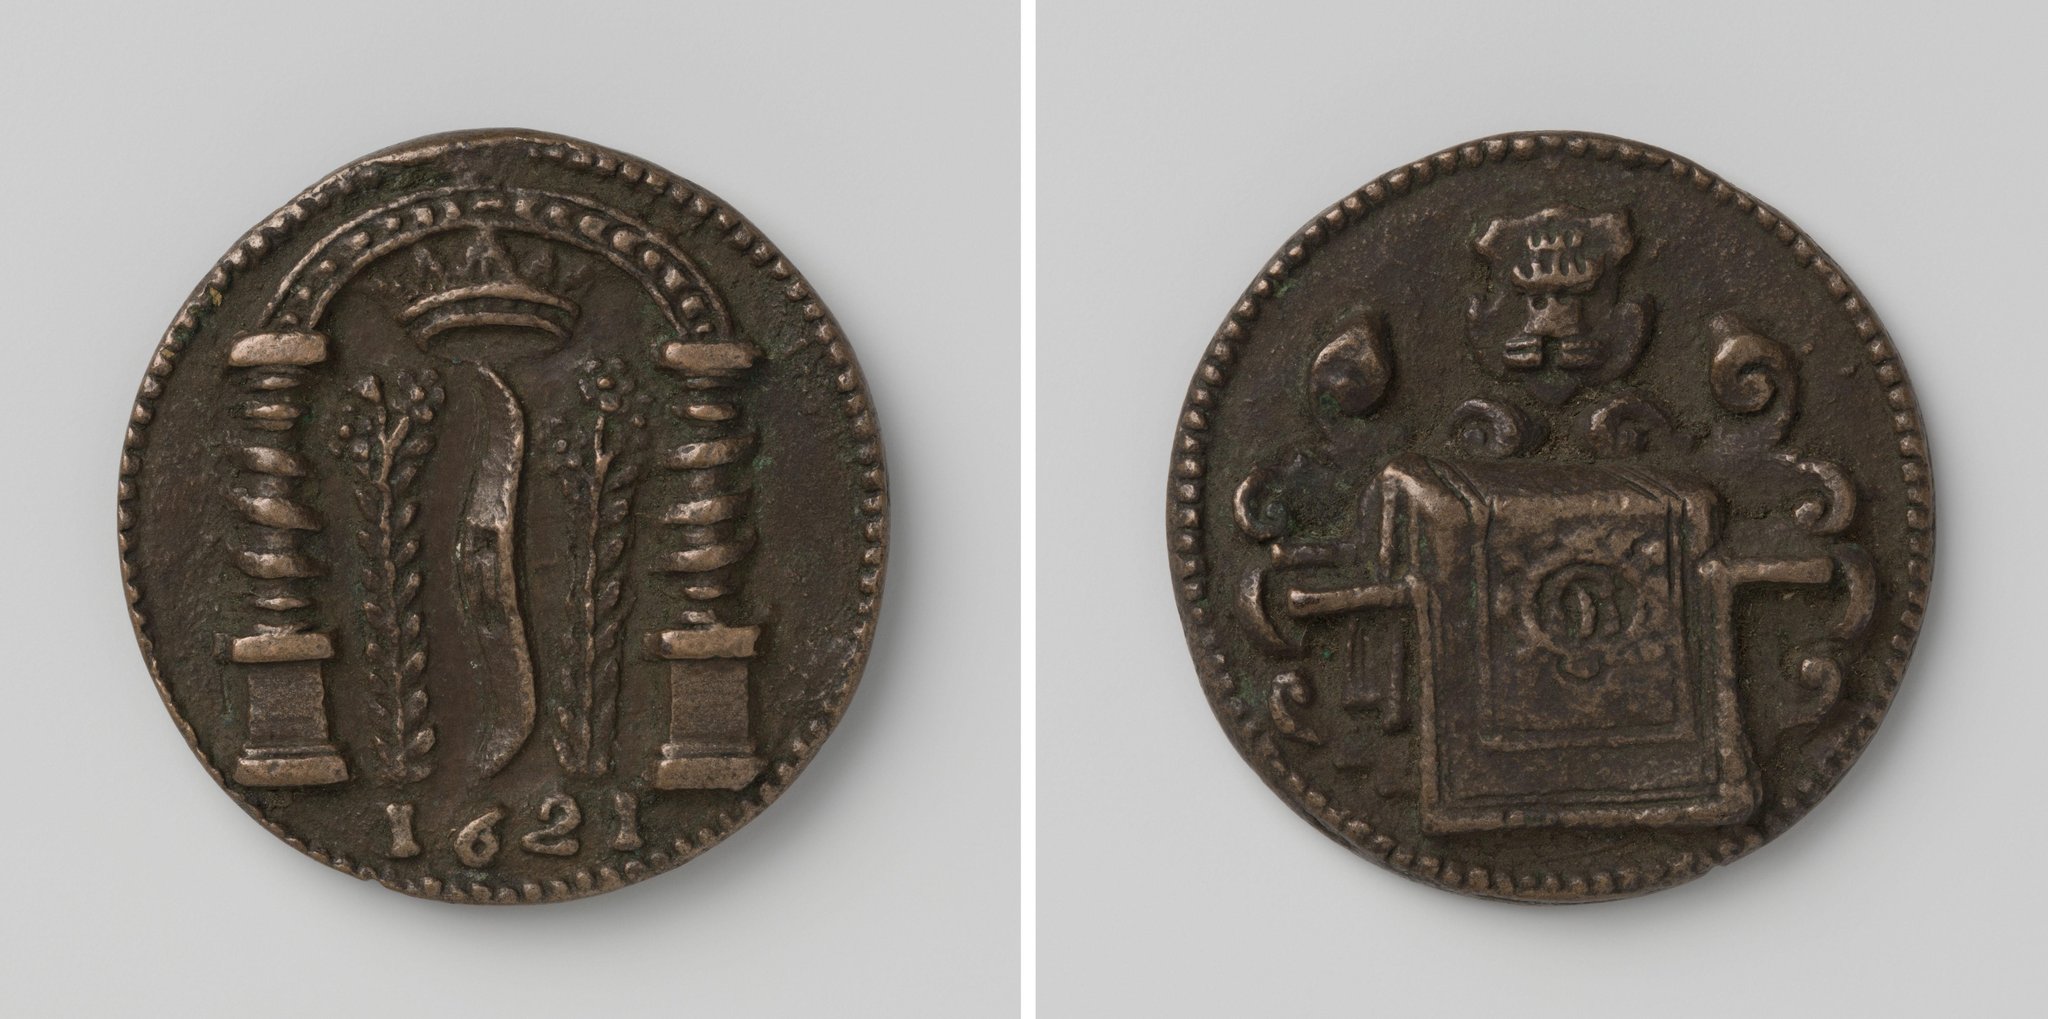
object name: funeral token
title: Weversgilde van Middelburg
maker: Anonymous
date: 1621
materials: copper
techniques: casting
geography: middelburg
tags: middelburg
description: Koperen penning. Voorzijde: gekroonde, opstaande weversspoel tussen twee bloeiende vlasplanten boven jaartal onder een op twee gekroonde pilaren rustende boog. Keerzijde: wapenschild boven lijkbaar, bedekt met geborduurd lijkkleed